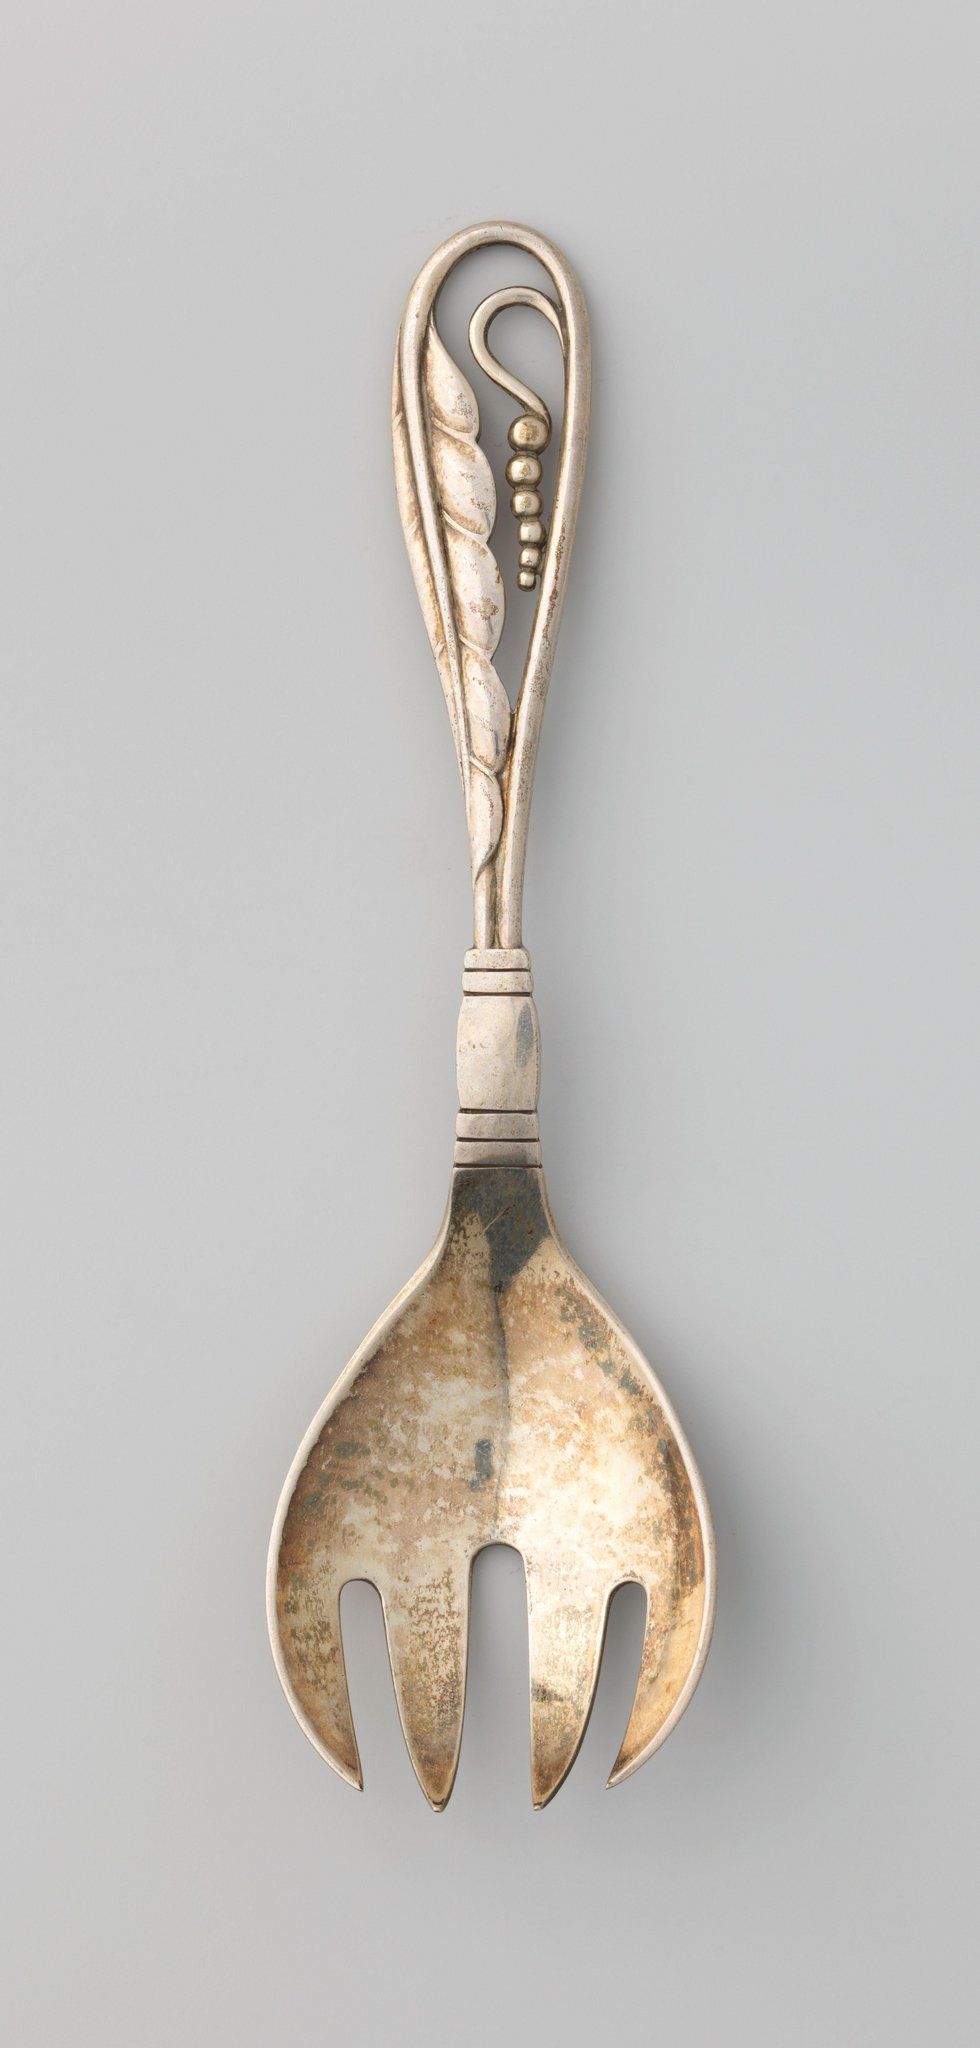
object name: fork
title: Vork van zilver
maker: georg jensen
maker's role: silversmith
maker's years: 1866-1935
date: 1918-1932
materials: silver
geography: copenhagen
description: Vork van zilver met vier korte, brede tanden, en gebogen zijden. De steel heeft een kort recht gedeelt en een lang lusvormig uiteinde met een opengewerkte versiering van een blad en steel met bessen.